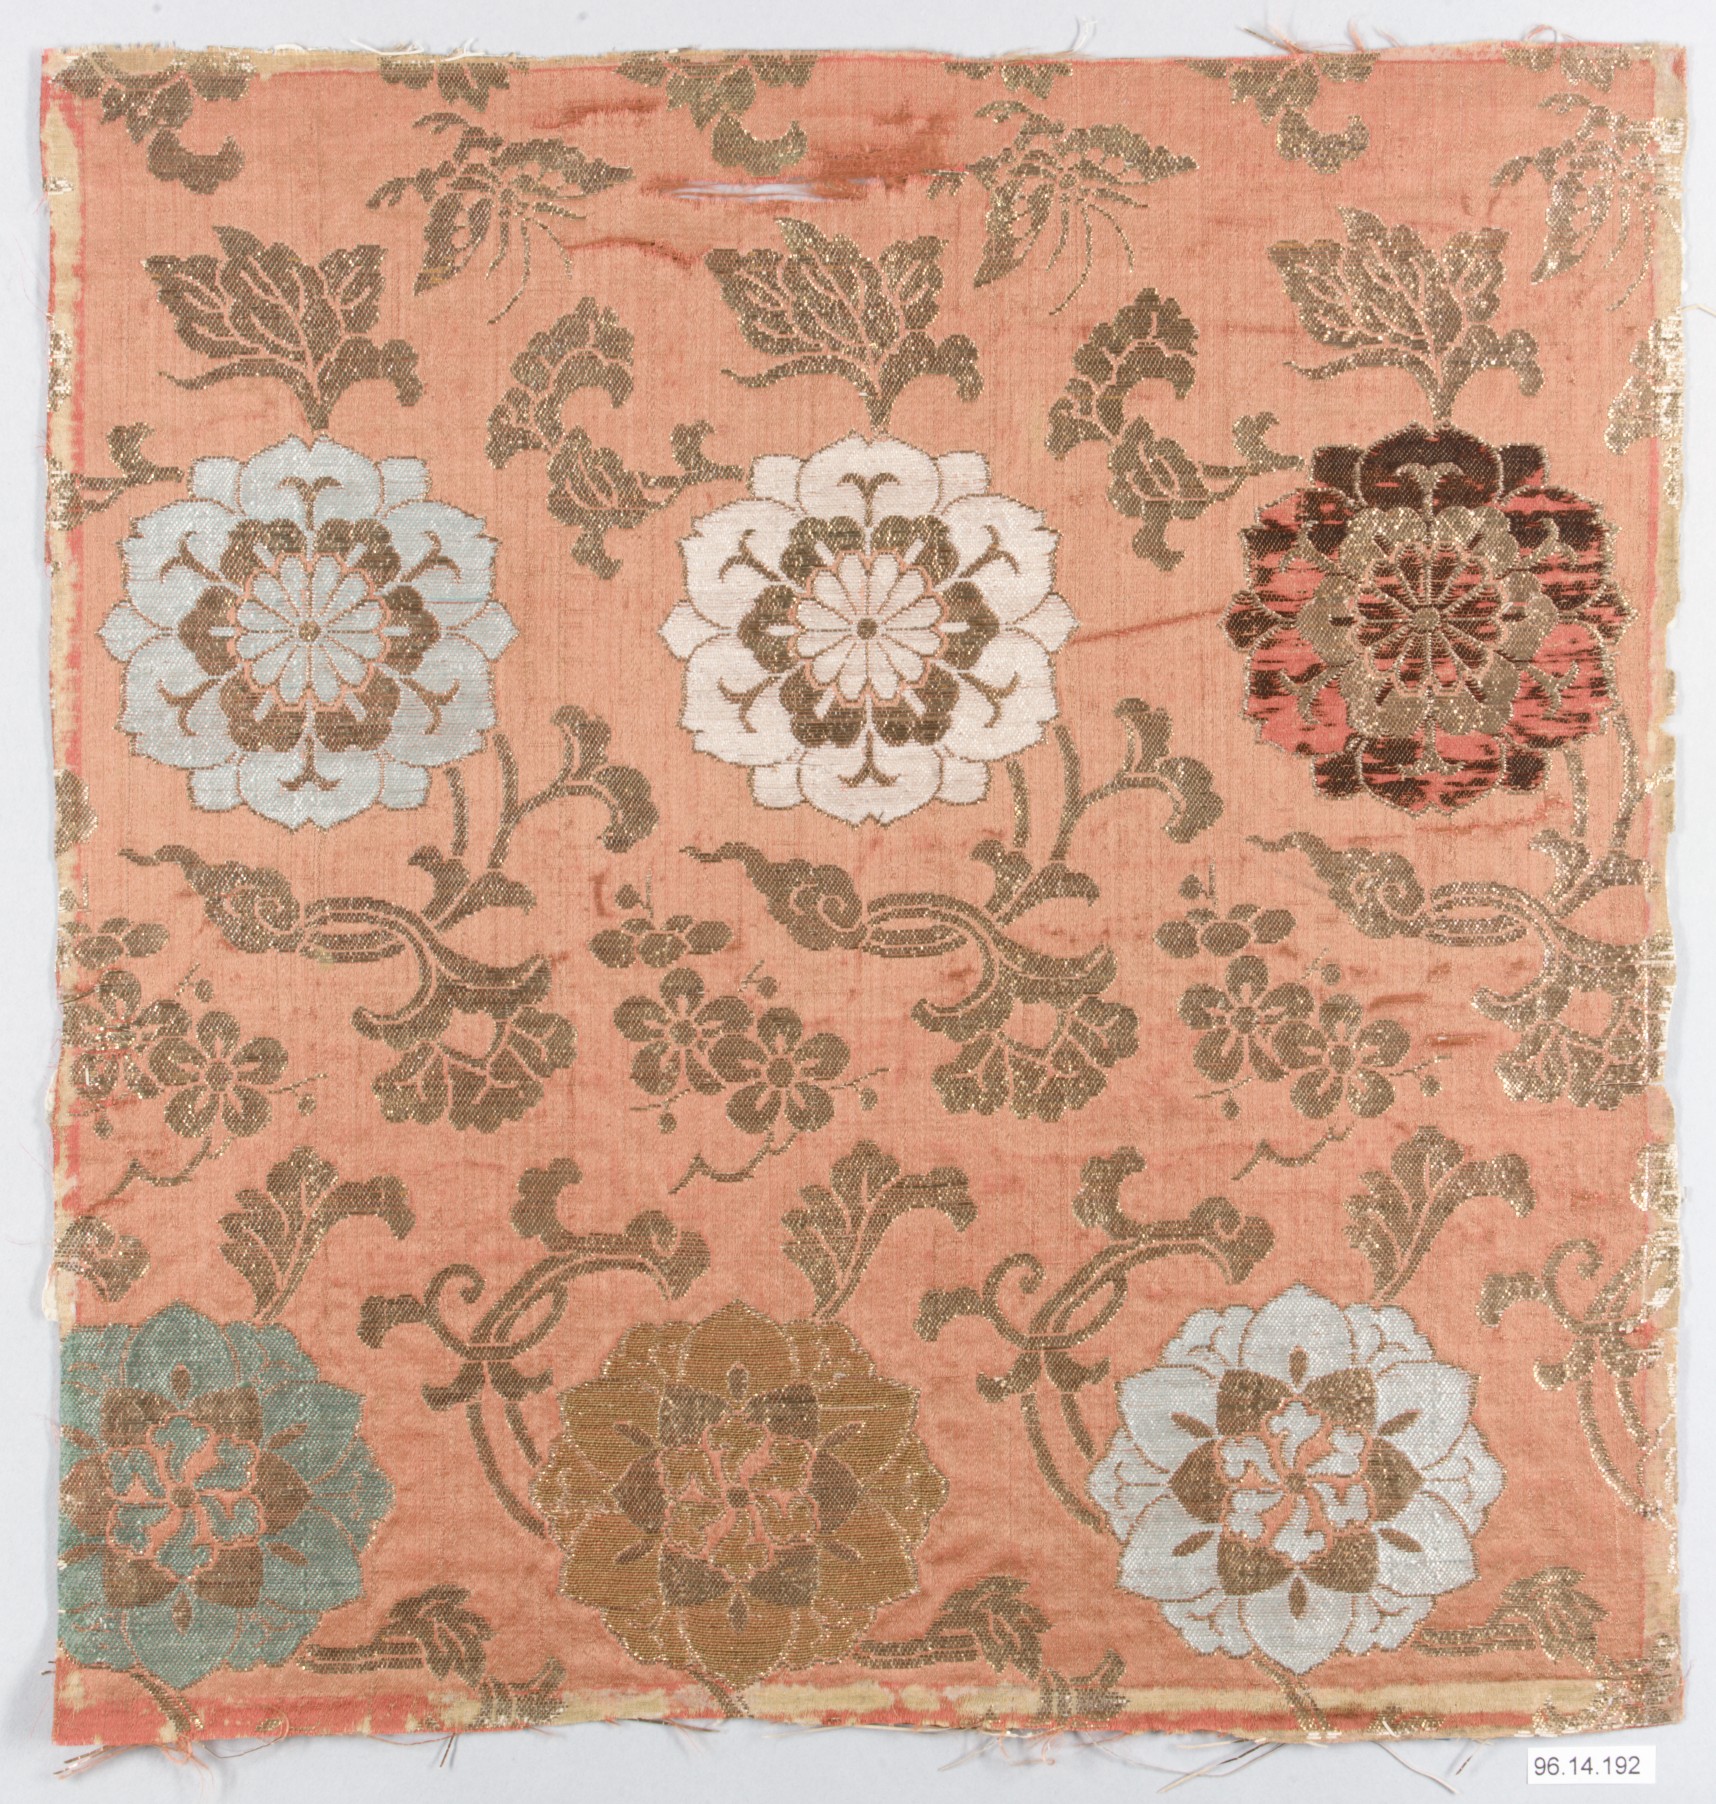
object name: piece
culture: japanese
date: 1701-1800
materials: metal thread, silk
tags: leaves